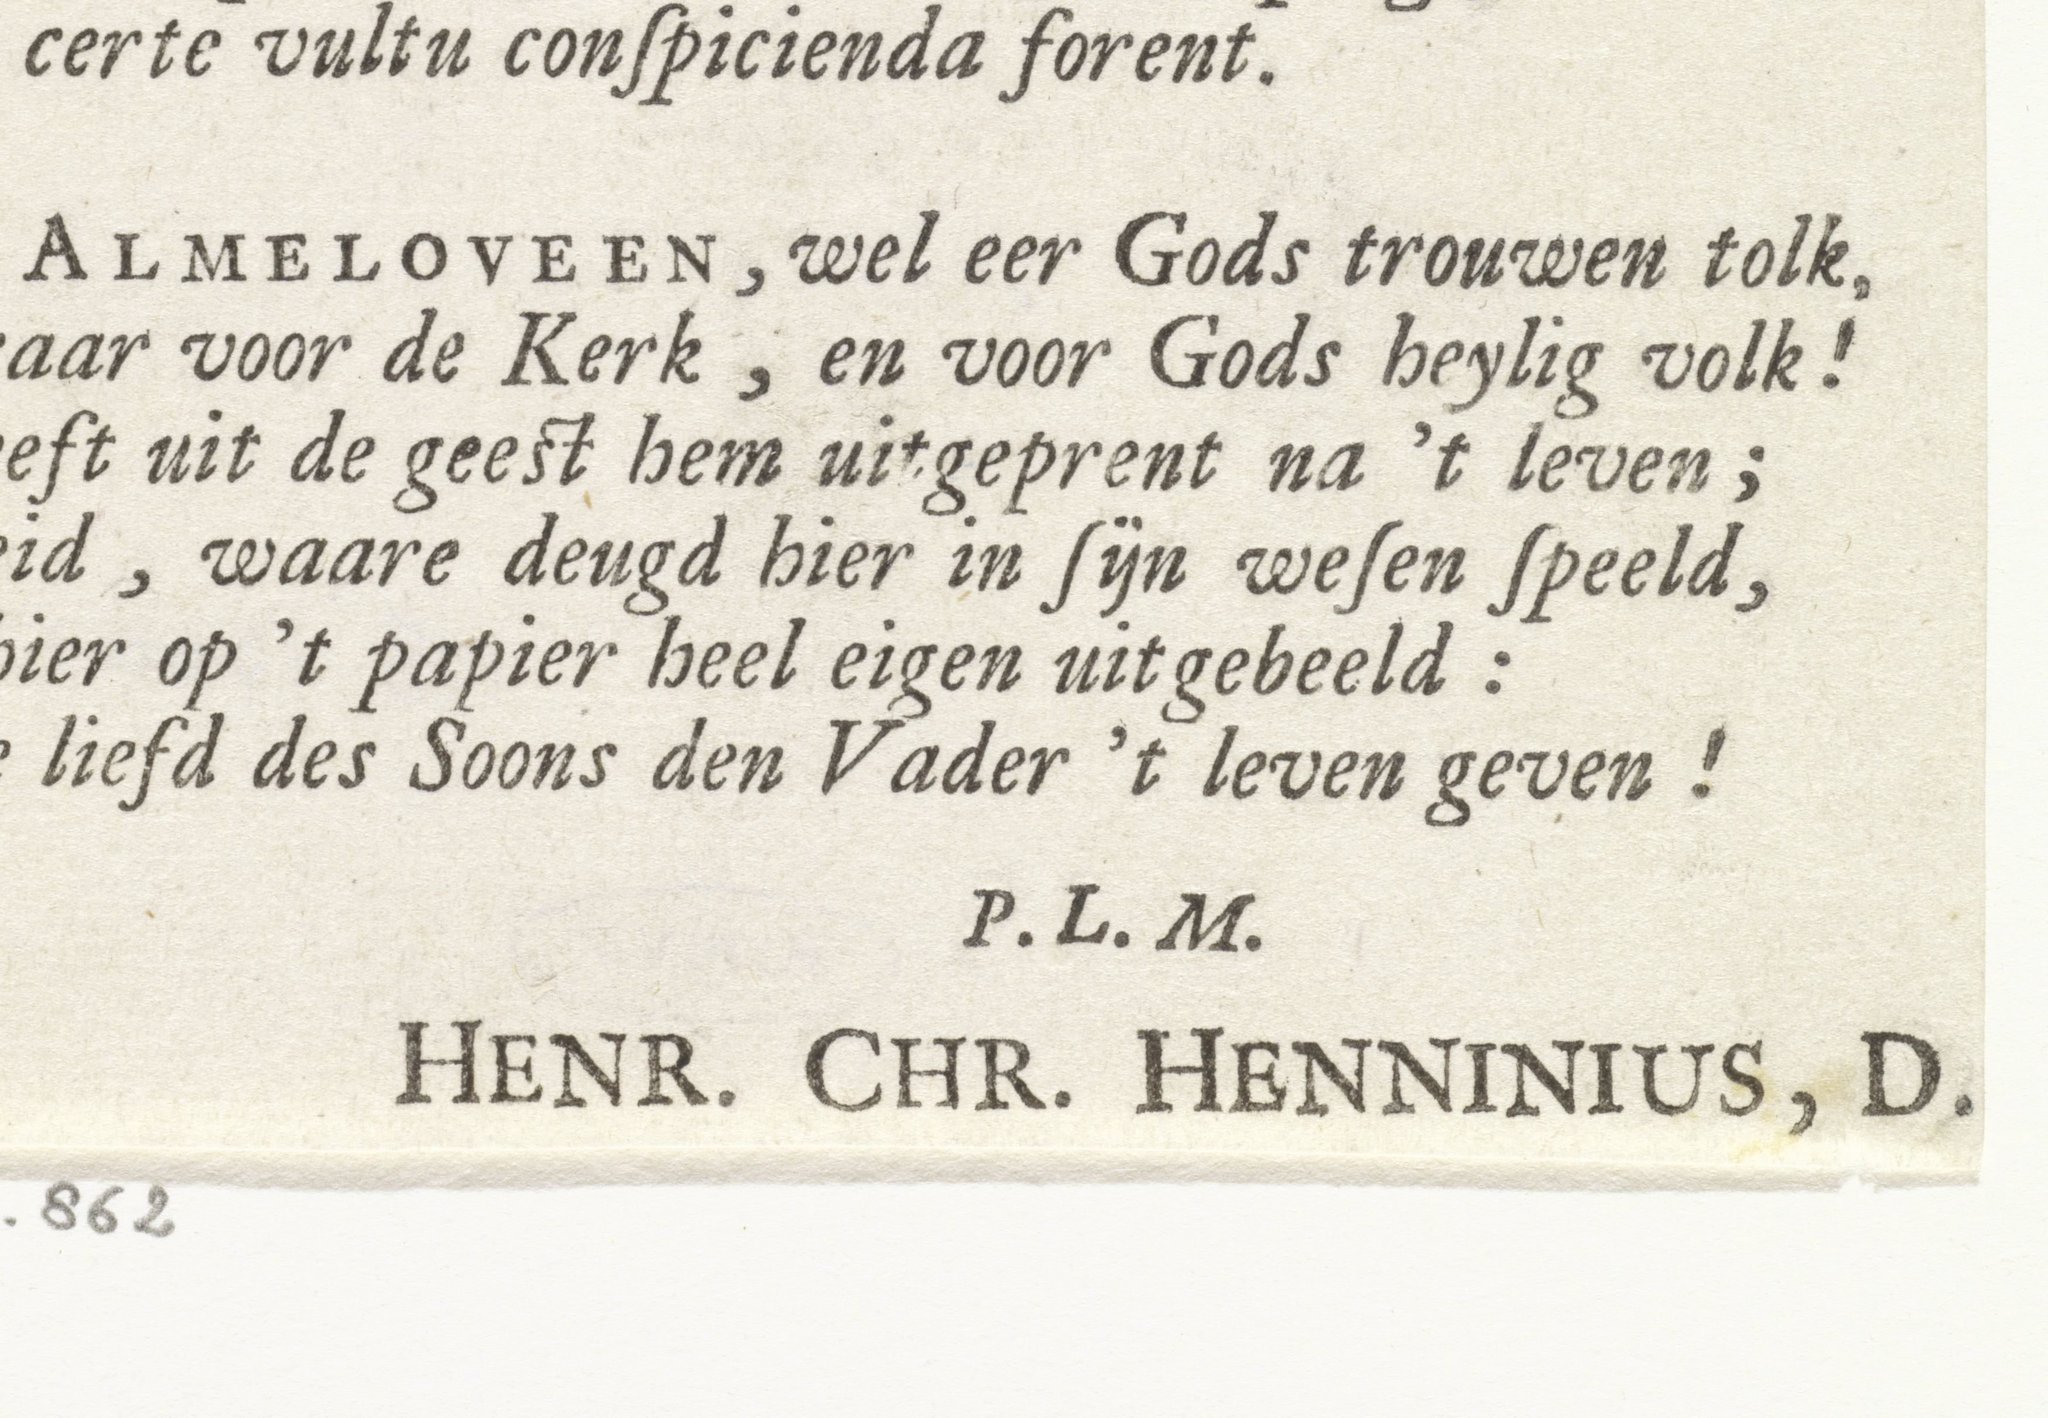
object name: print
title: Gedicht bij Jan van Almeloveens' portret van Johannes ab Almeloveen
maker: henricus christianus henninius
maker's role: schrijver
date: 1678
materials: paper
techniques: letterpress printing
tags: johannes ab almeloveen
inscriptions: collector's mark: Lugt 2228